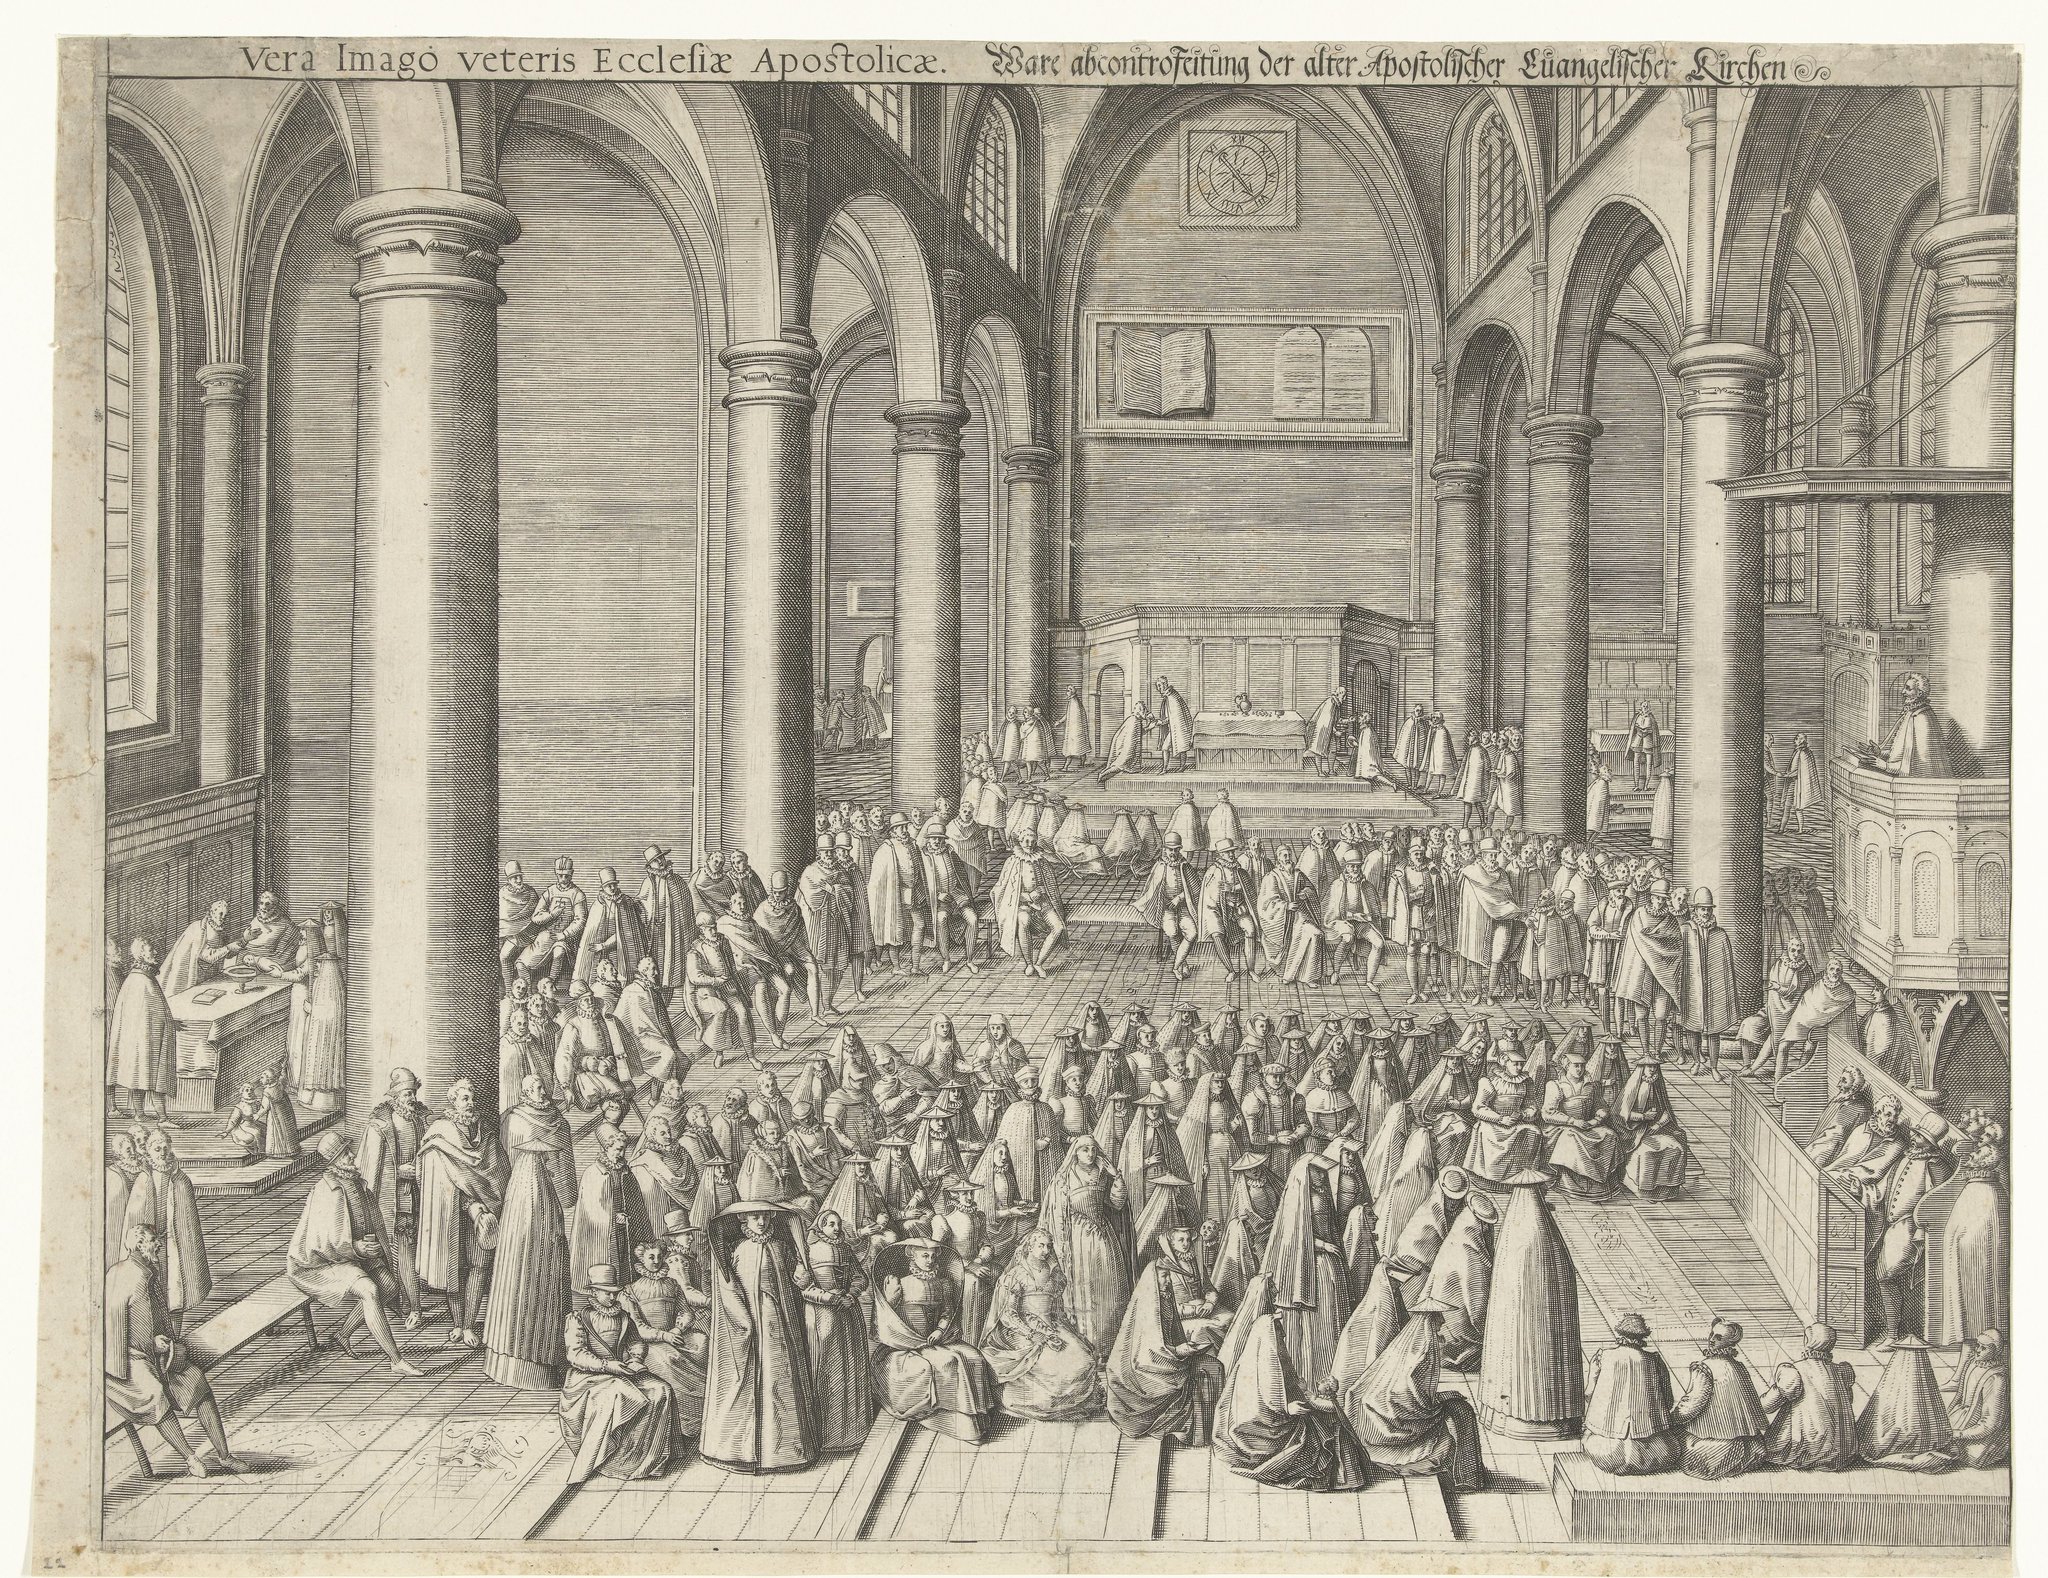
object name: print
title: Vera imago veteris ecclesiae apostolicae. Ware abcontrofeiting der alter Apostolischer Kirchen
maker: robert de baudous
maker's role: print maker, publisher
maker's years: 1574-1659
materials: paper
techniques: engraving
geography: amsterdam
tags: interior of church, protestant service, holy communion ~ protestant service, baptism ~ protestant service, sermon ~ protestant service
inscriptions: collector's mark: Lugt 2228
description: Preek in een protestantse kerk. Rechts de predikant op een preekstoel. Links een predikant een kind dopend. In het midden bedienen twee predikanten het avondmaal.